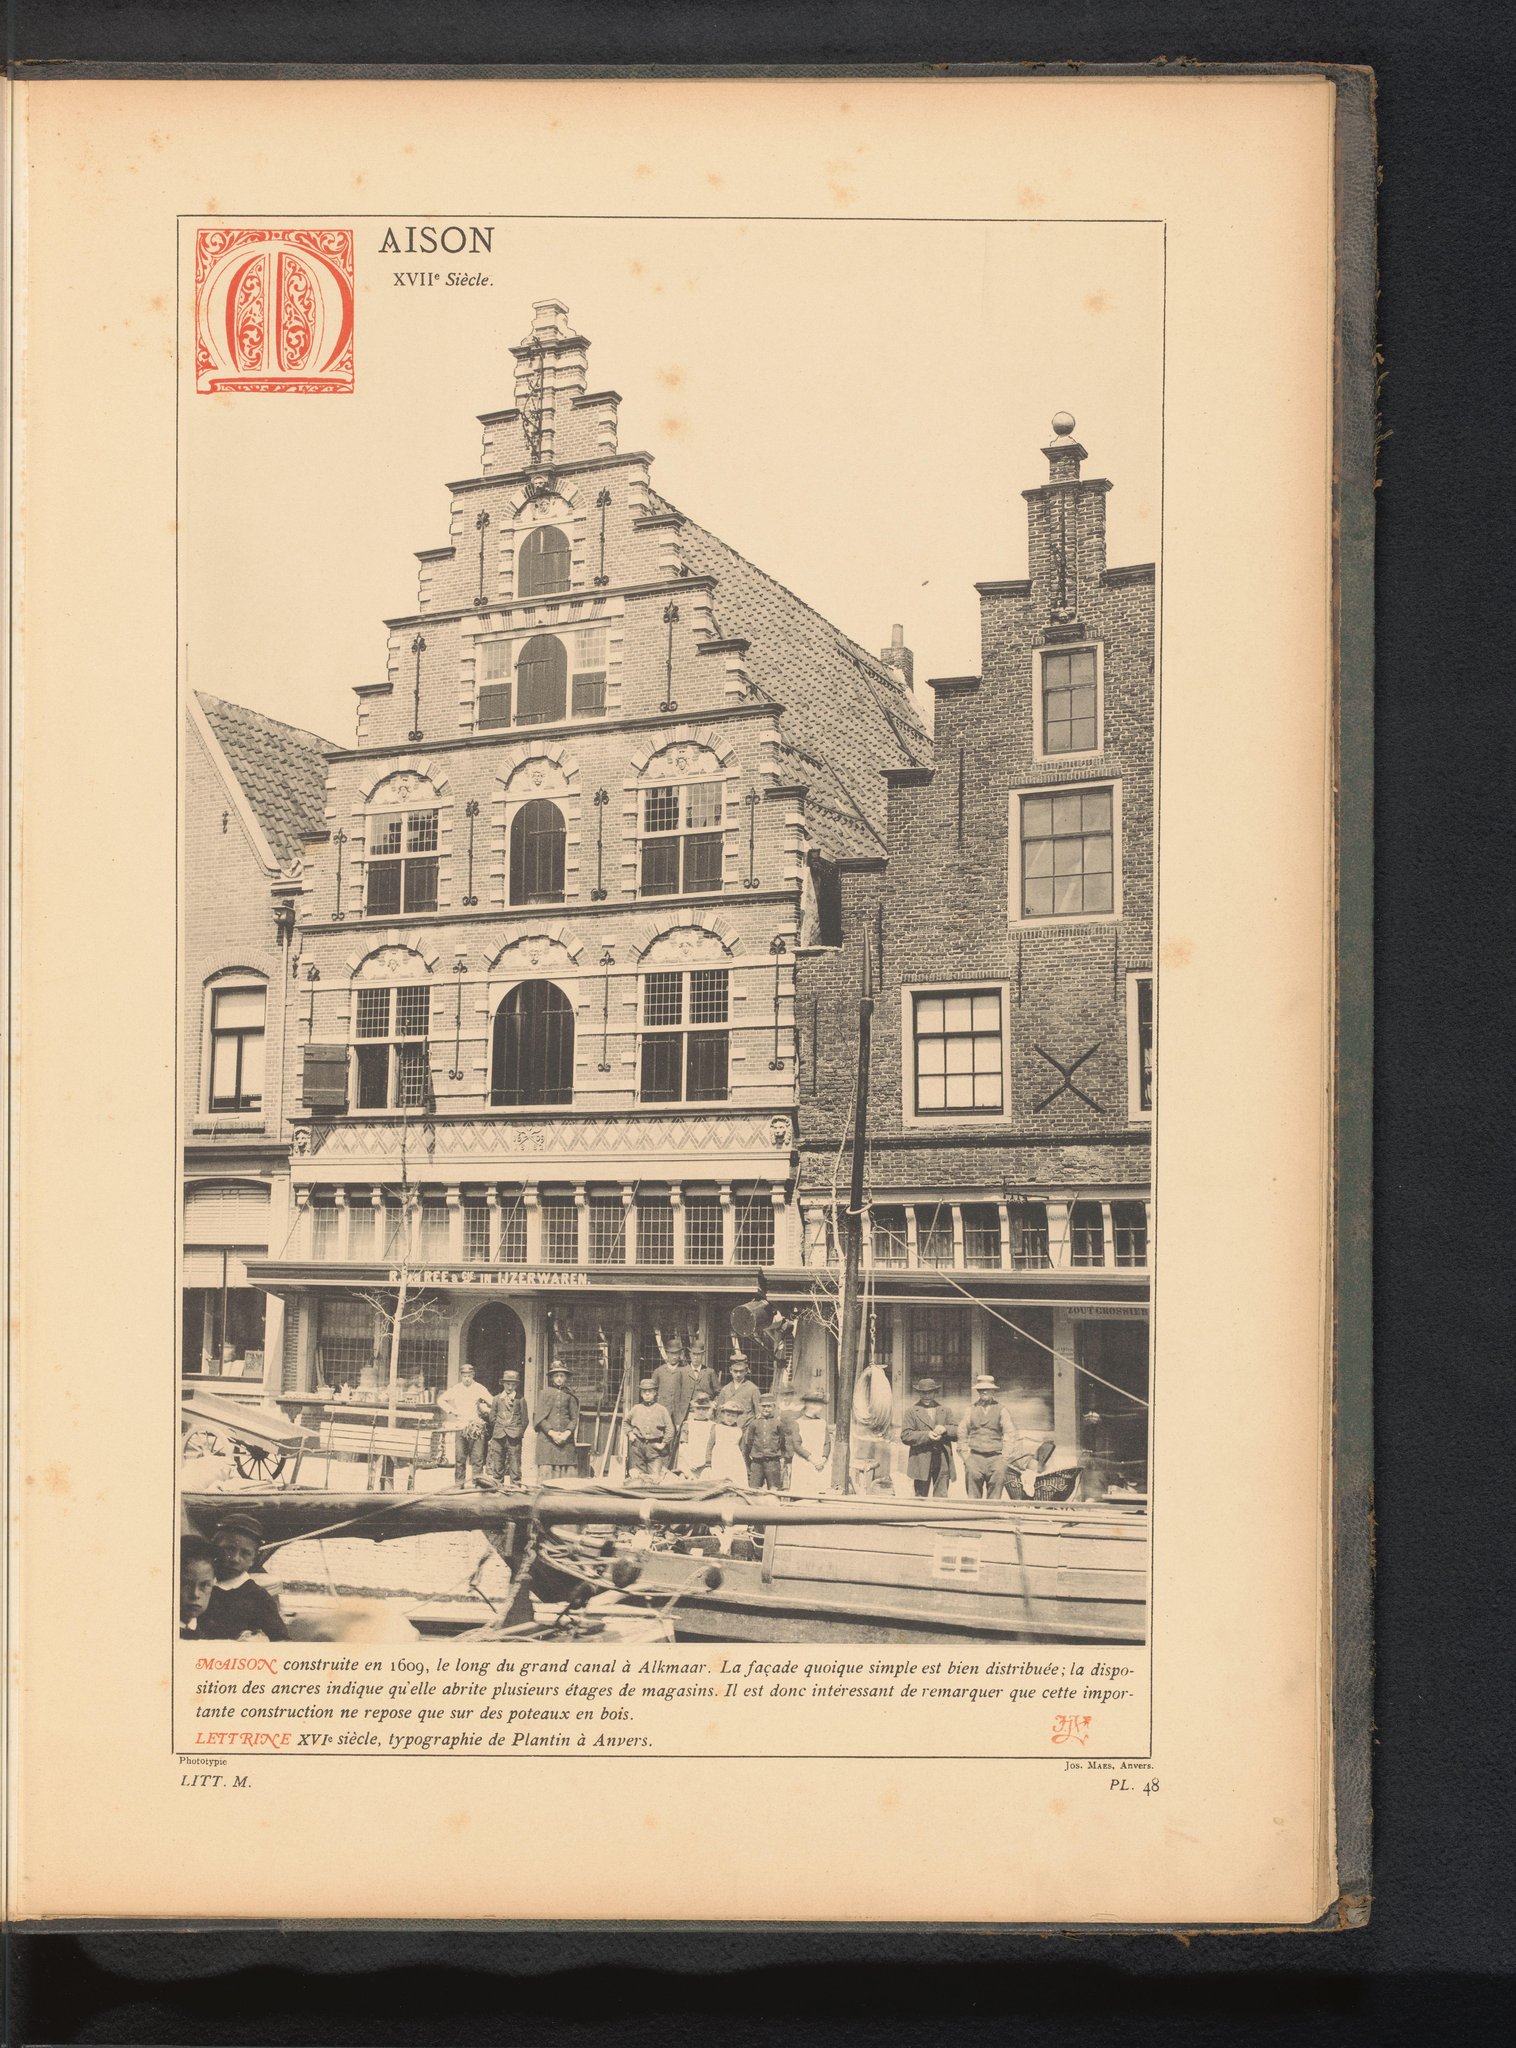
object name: photomechanical print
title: Huis in Alkmaar, met op de voorgrond mannen en kinderen op een kade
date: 1875-1880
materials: paper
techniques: photograph, photolithography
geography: alkmaar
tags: civic architecture; edifices; dwellings, canals, waters (in city) (+ city(-scape) with figures, staffage)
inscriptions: inscription: ‘LITT. M. - PL. 48’, monogram: ‘JJvY’, inscription: ‘MAISON construite en (...)’